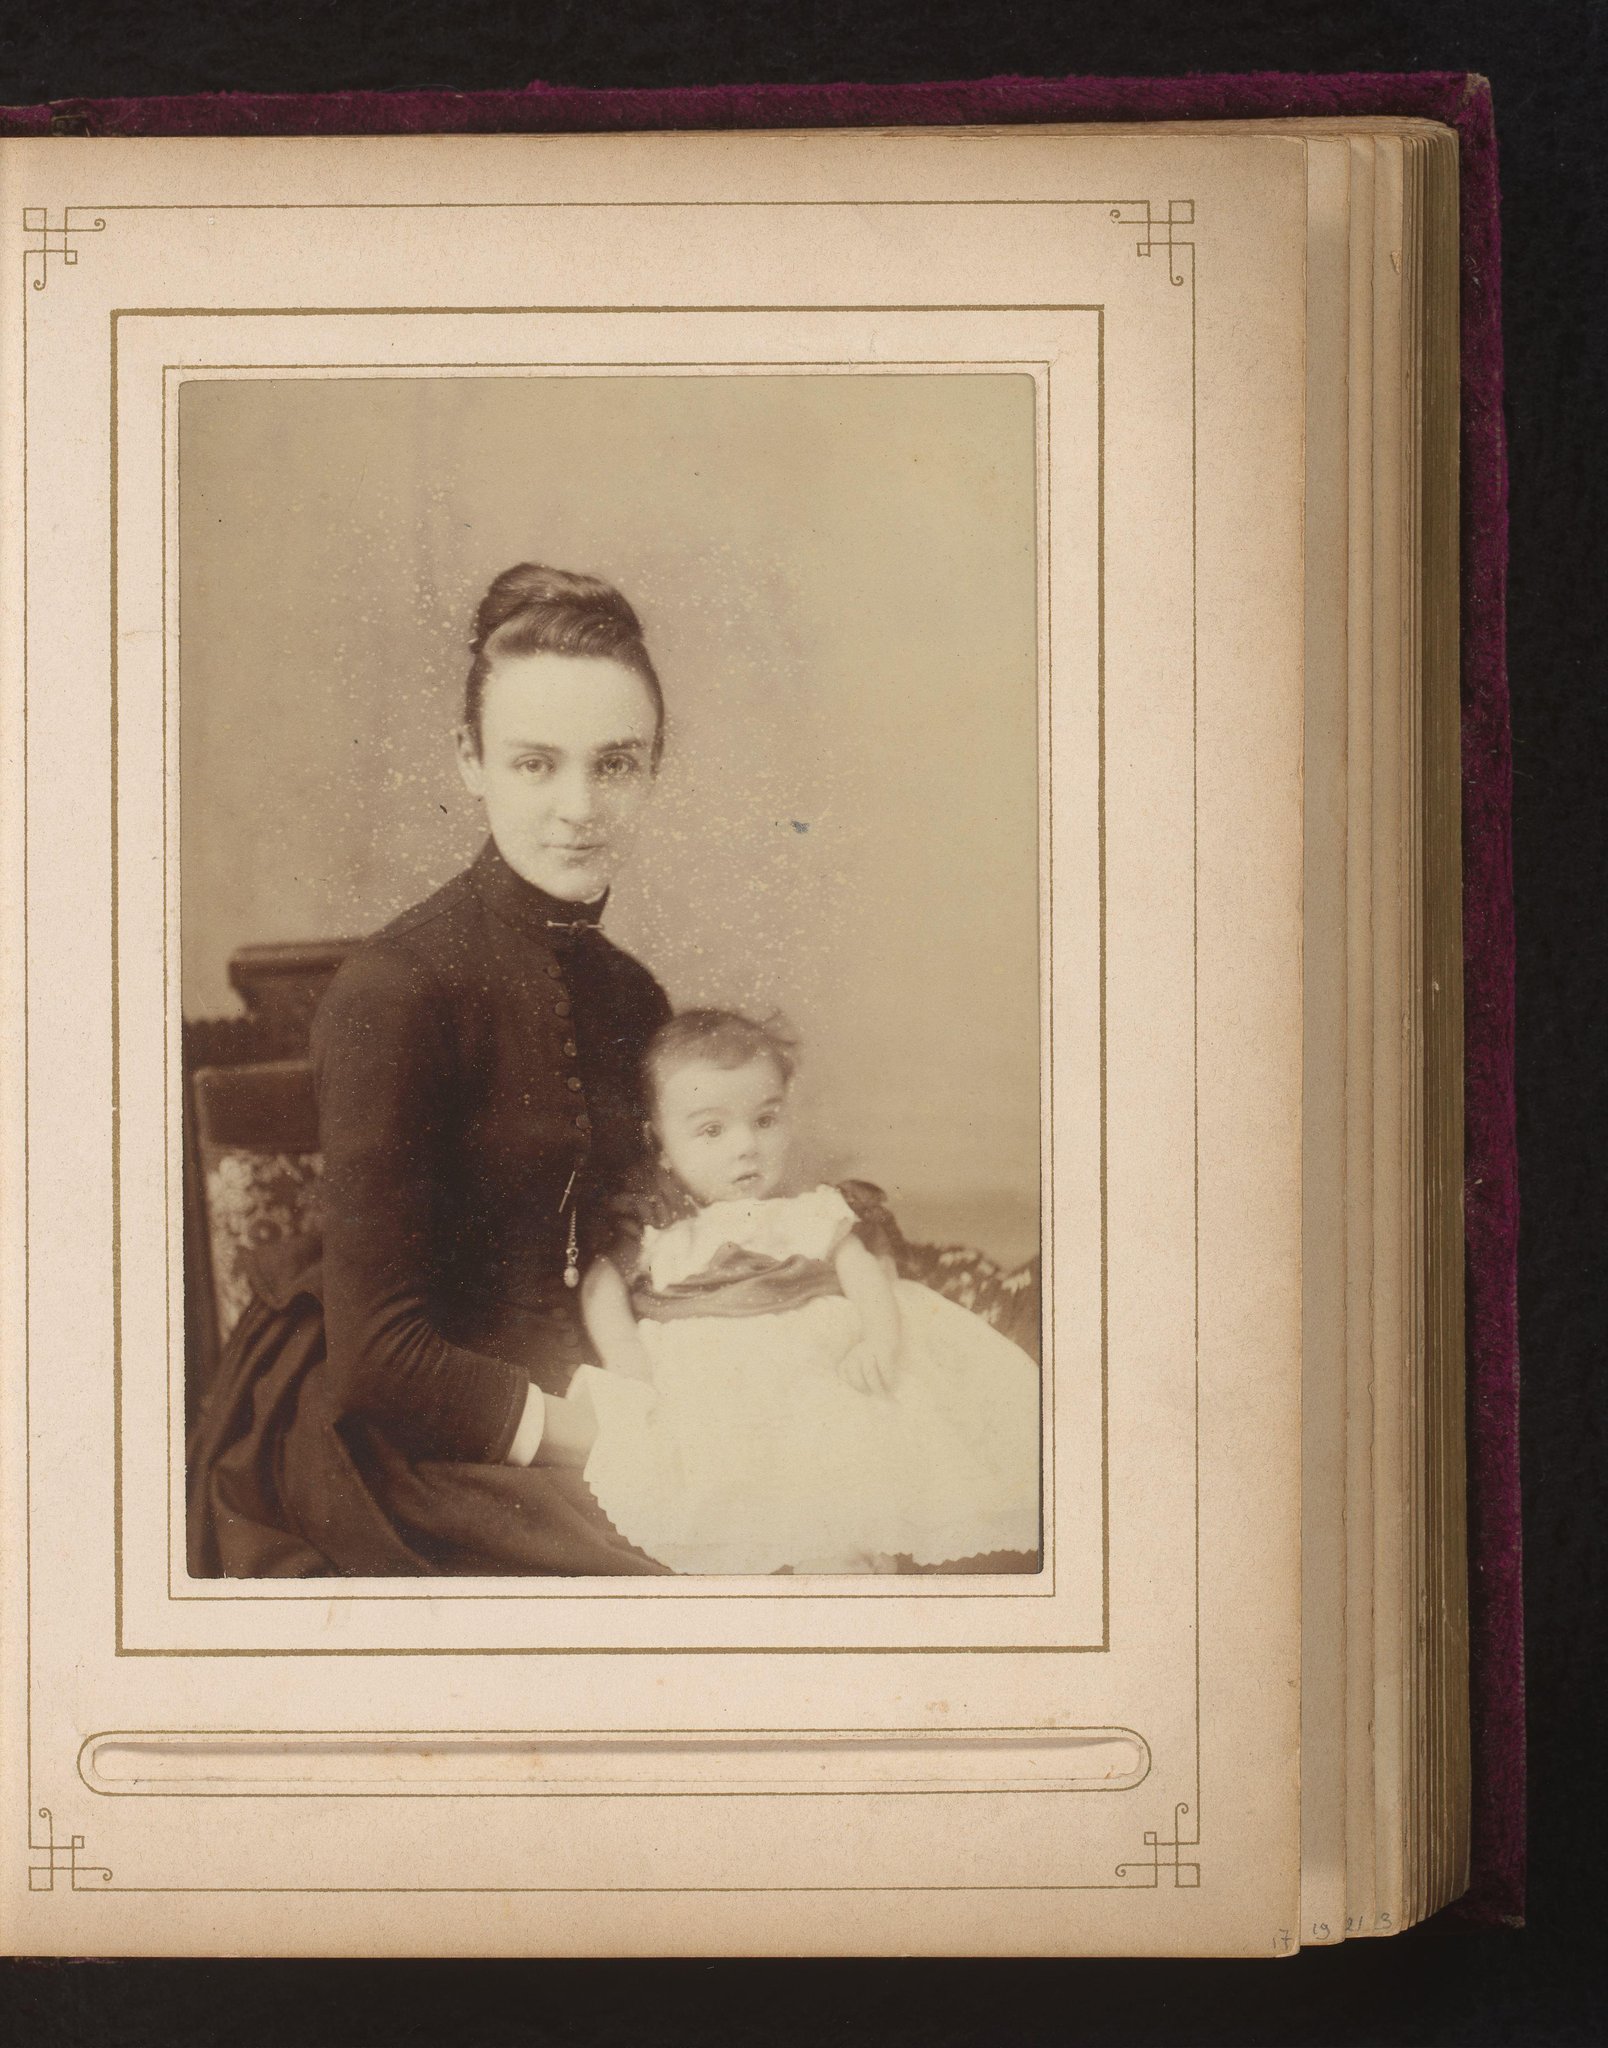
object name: photograph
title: Portret van een zittende vrouw met baby op schoot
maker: hanna hatherly maynard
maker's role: fotograaf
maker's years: 1834-1918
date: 1860-1900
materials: cardboard, photographic support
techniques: albumen print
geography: victoria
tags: sitting figure - aa - female human figure, historical persons - bb - woman, infant, baby ~ the ages of man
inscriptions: inscription: ‘Mrs. R. MAYNARD,/ PHOTOGRAPHIC ARTIST/ And Dealer in All Kinds of/ Photographic Materials/ Stereoscopic and Large Views of British Columbia and Vancouver Island/ for Sale./ Cor. Douglas & Johson Streets,/ Victoria, B. C.’